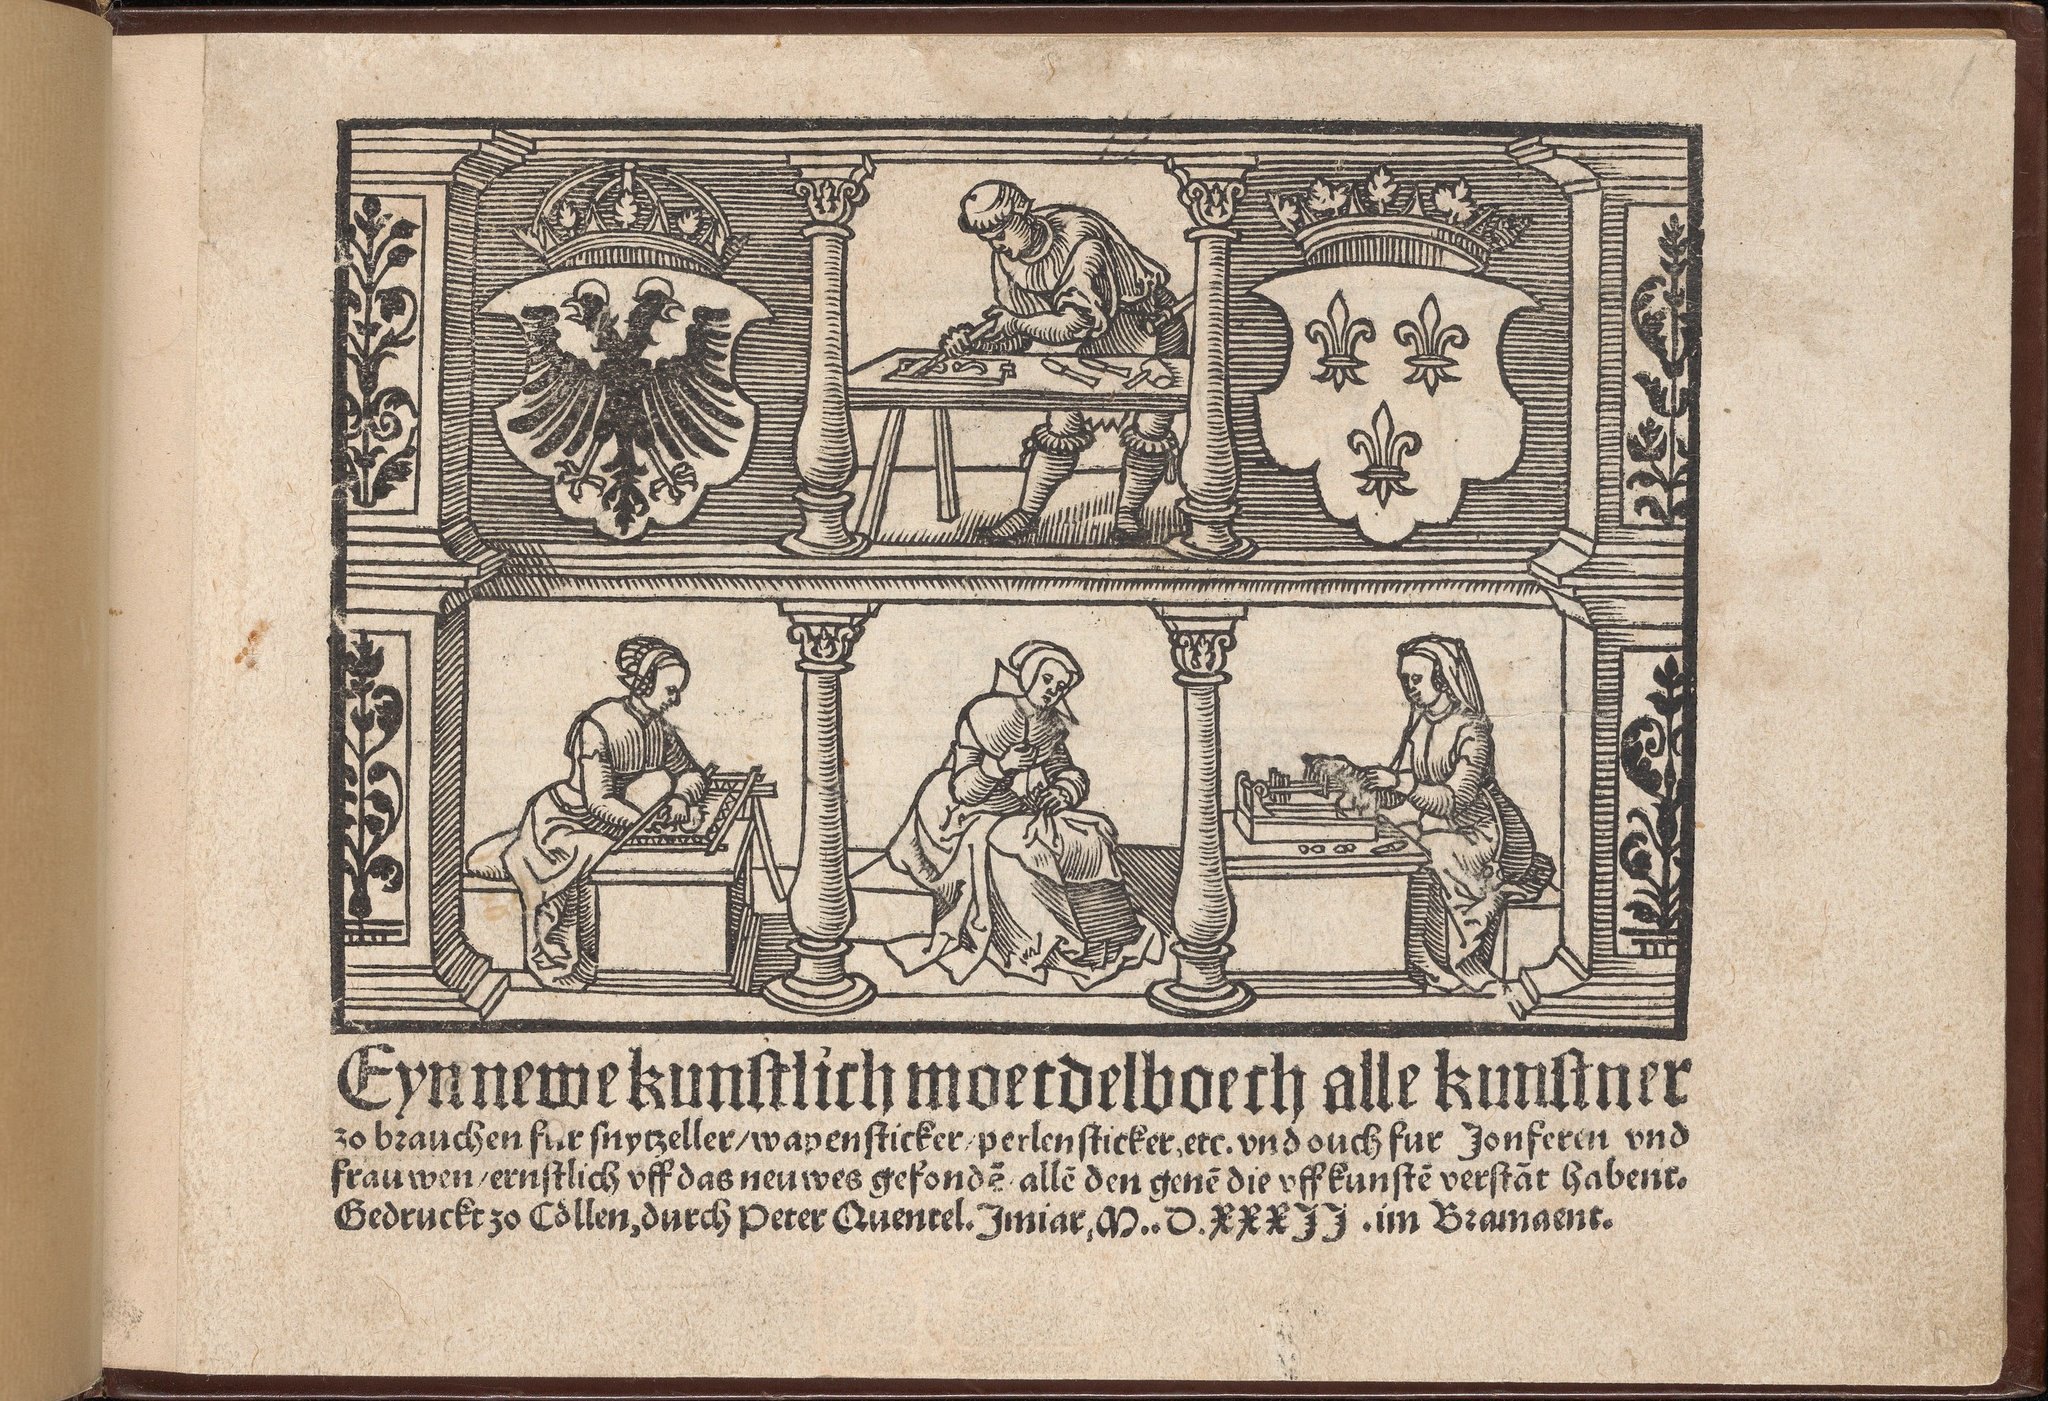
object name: book print ornament architecture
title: Eyn Newe kunstlich moetdelboech alle kunst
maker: peter quentel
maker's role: publisher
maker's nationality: german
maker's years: 1500-1550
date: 1532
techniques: woodcut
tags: men,women,coat of arms